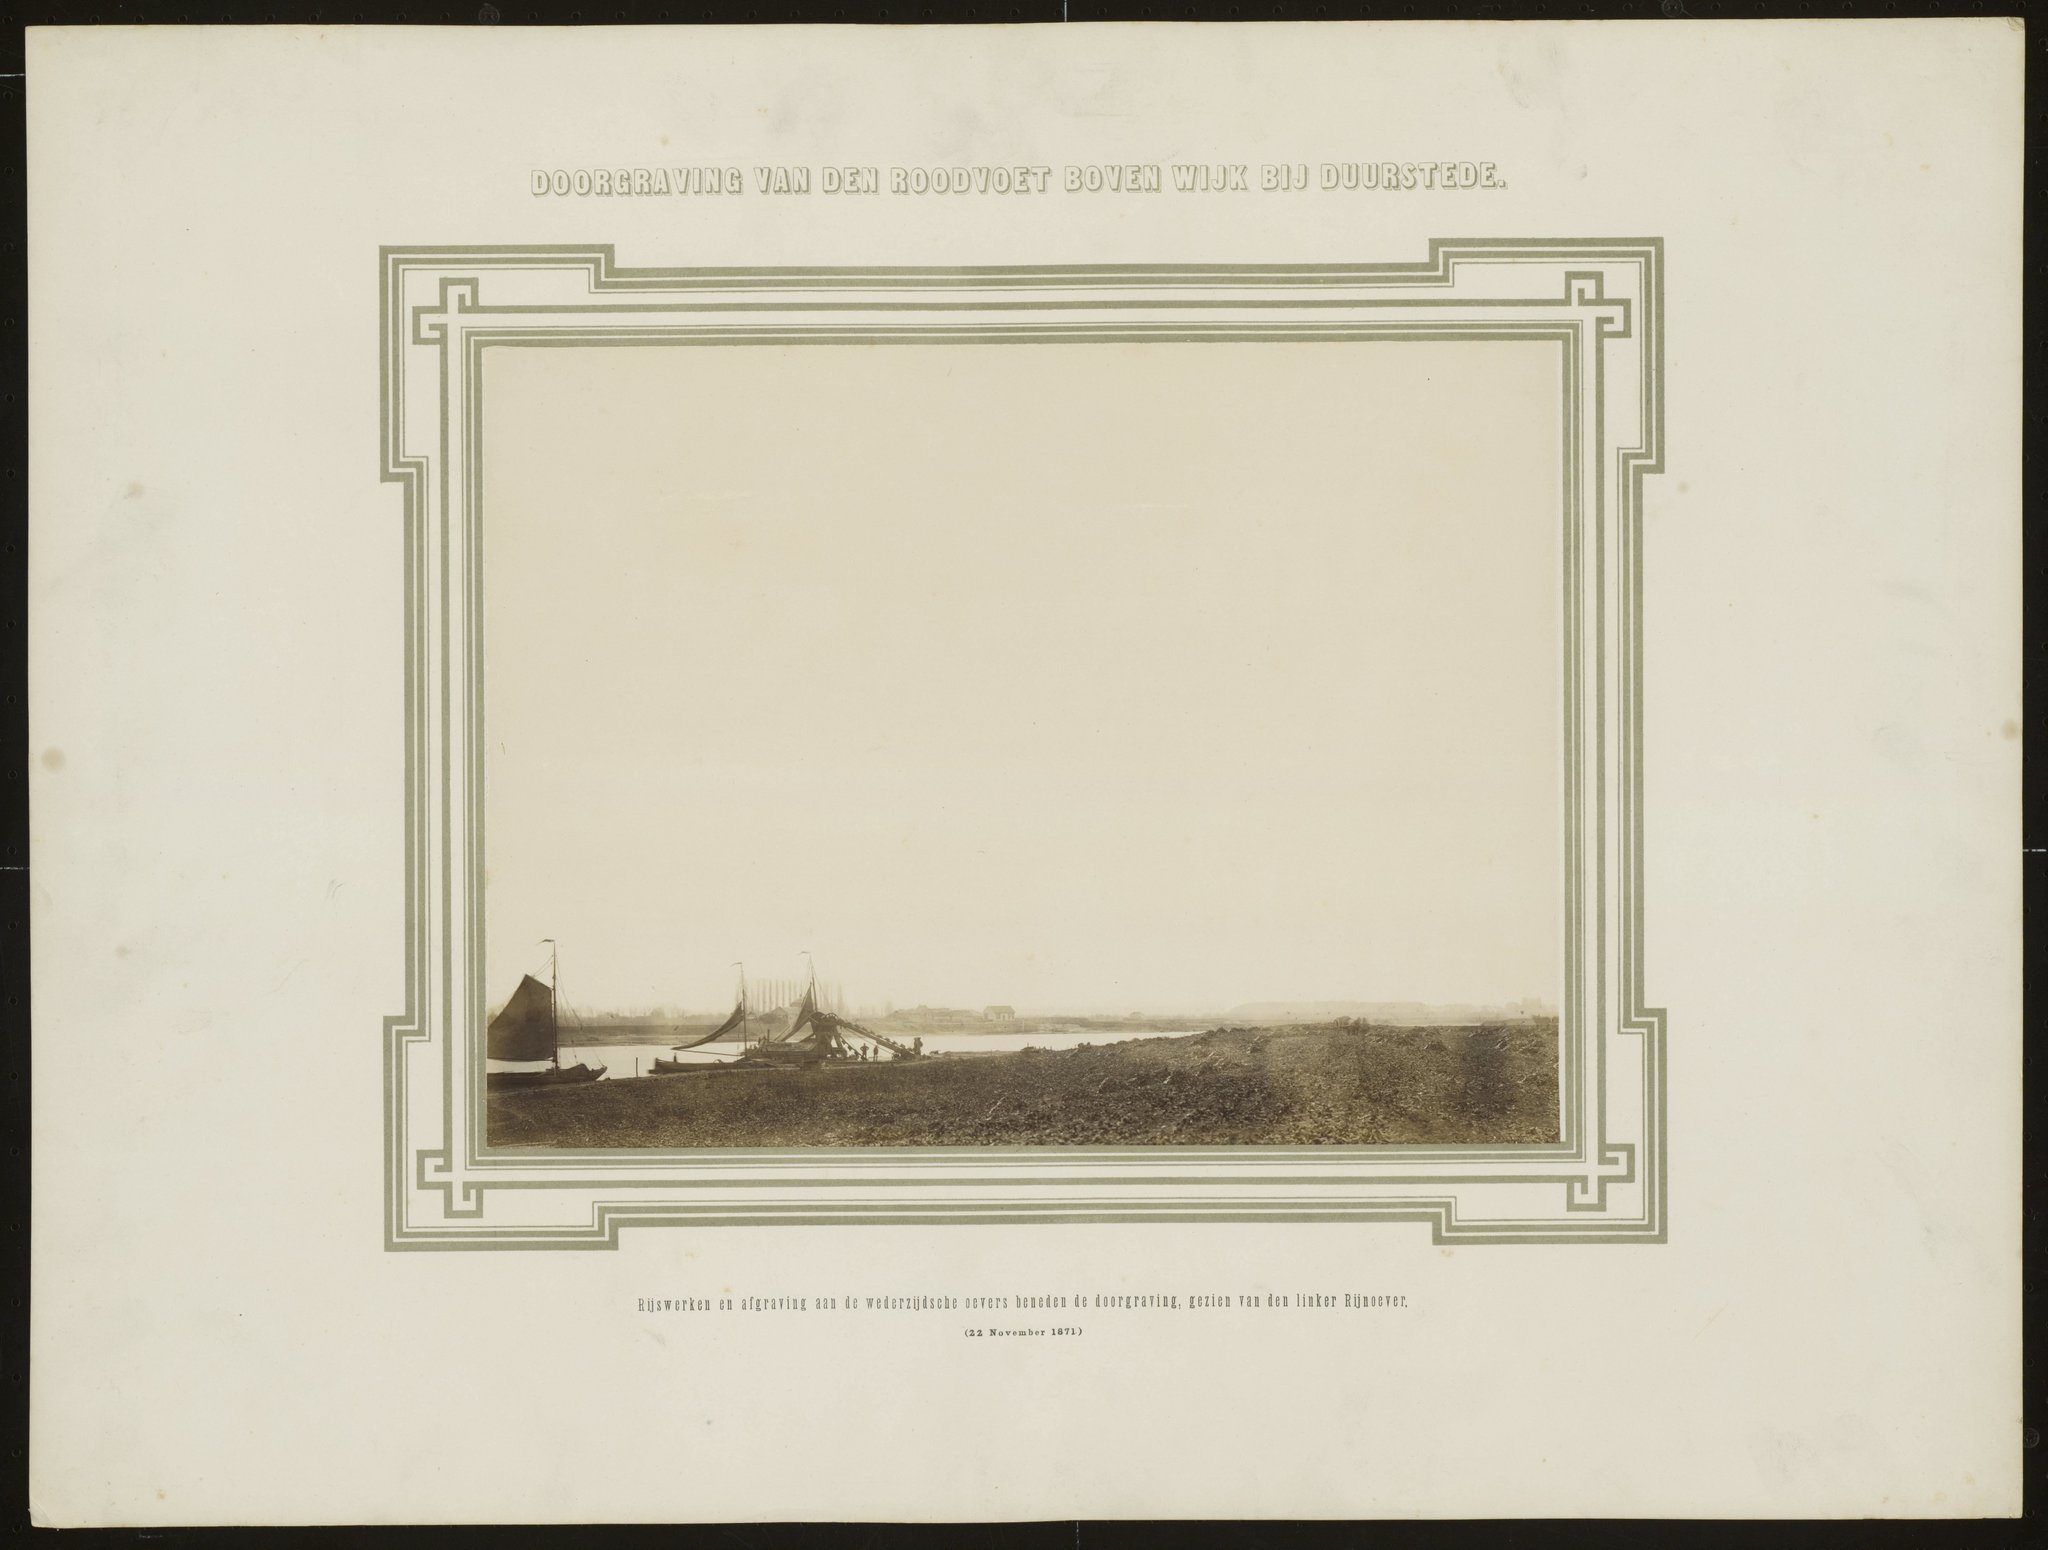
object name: photograph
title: Rijswerken en afgraving aan de wederzijdsche oevers beneden de doorgraving, gezien van den linker Rijnoever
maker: Anonymous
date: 1871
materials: cardboard, paper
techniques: photography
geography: wijk bij duurstede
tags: wijk bij duurstede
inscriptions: date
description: Foto op karton van waterbouwkundige werkzaamheden aan een kanaal.